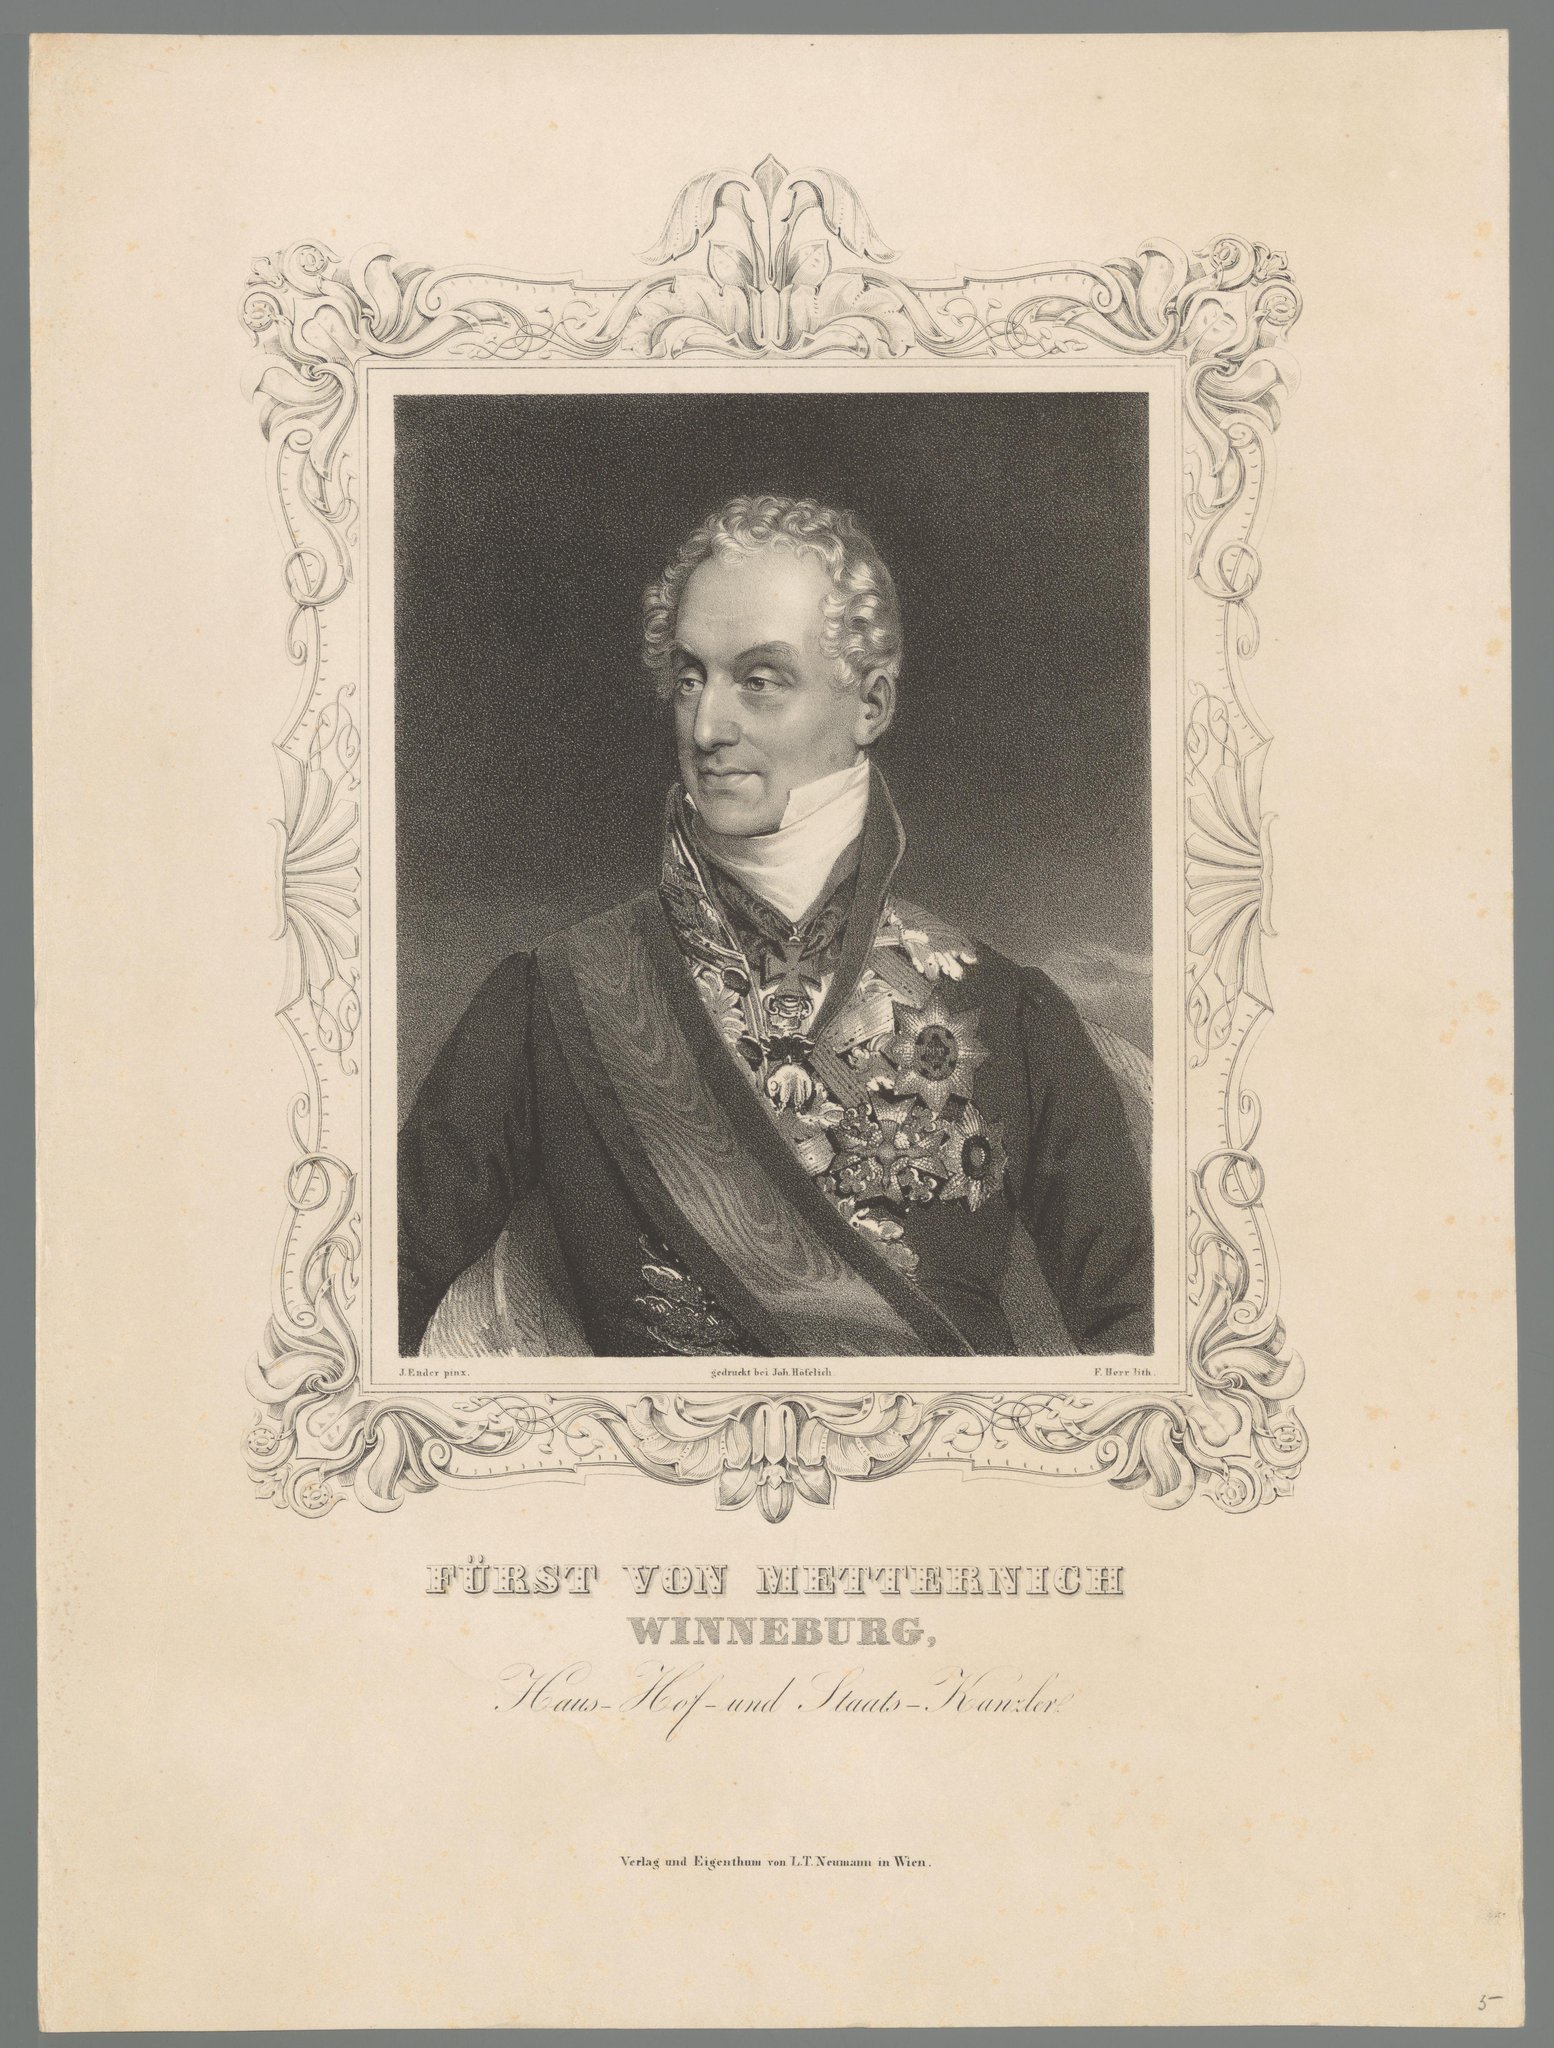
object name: print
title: Fürst von Metternich Winneburg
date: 1814-1849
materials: paper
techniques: lithograph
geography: vienna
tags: vienna, official; civil servant; functionary (in general), historical persons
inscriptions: collector's mark: Lugt 2228